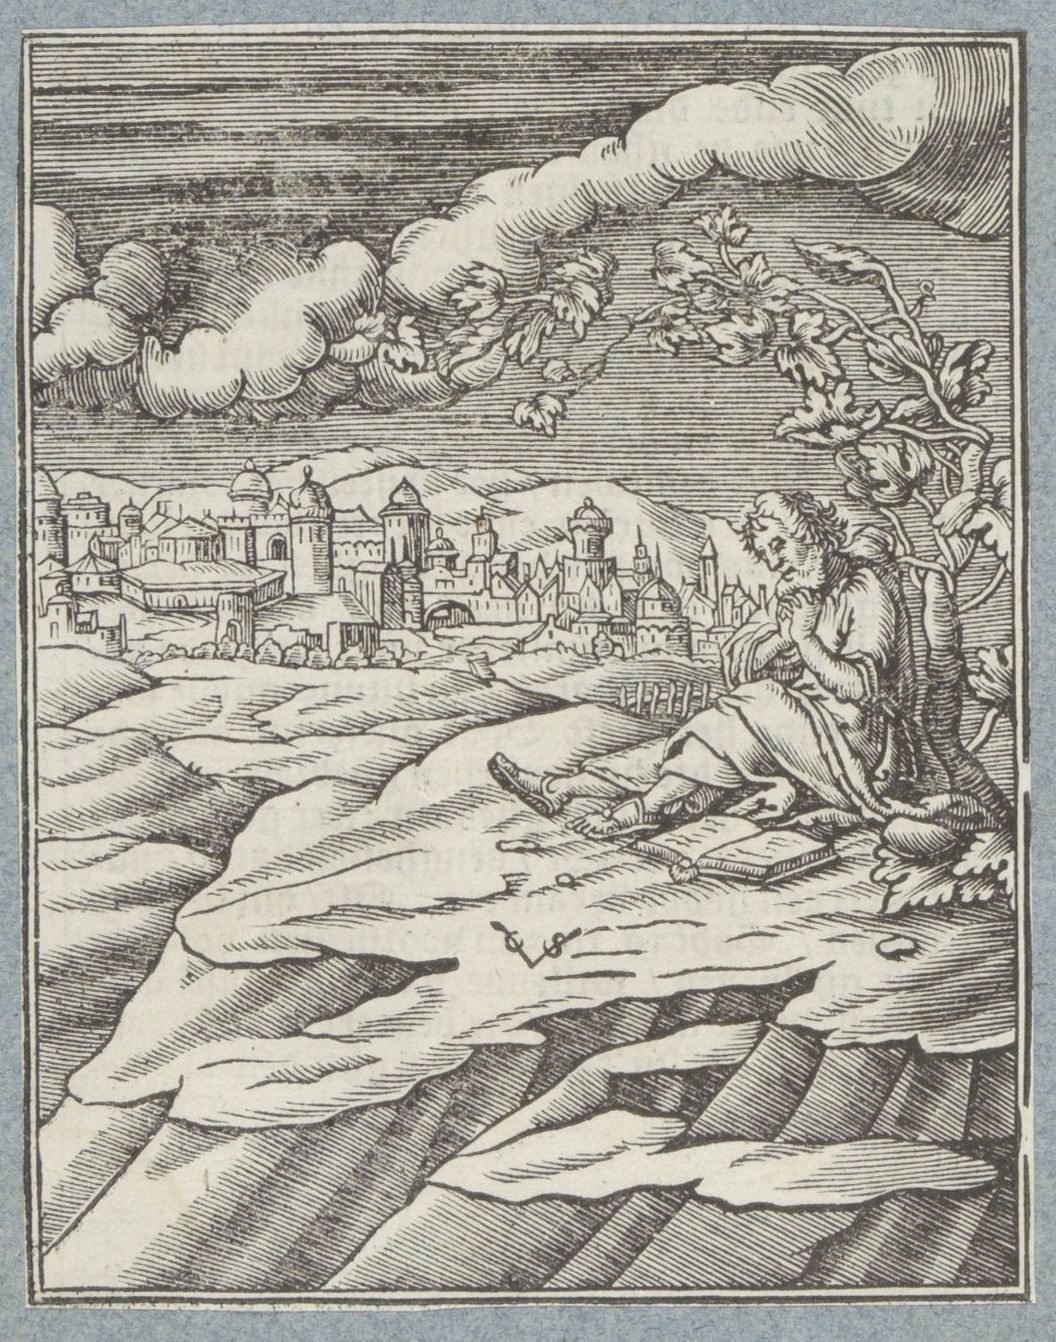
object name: print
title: Jona zit onder de wonderboom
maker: pieter jacobsz. paets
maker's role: publisher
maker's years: 1587-1667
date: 1645-1657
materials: paper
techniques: letterpress printing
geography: amsterdam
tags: the prophet jonah withdraws from nineveh; he builds a booth and while enjoying the shade of a plant (gourd or vine) which god made grow for him, he awaits the destiny of the city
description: Jona zit met uitzicht op de stad Nineve te wachten tot God de stad zal vernietigen. God heeft een wonderboom voor hem laten groeien, zodat hij in de schaduw kan zitten. Maar de volgende dag is de boom verdord, de bladeren hangen slap, en Jona wordt bevangen door de hitte. De prent maakt deel uit van een album.